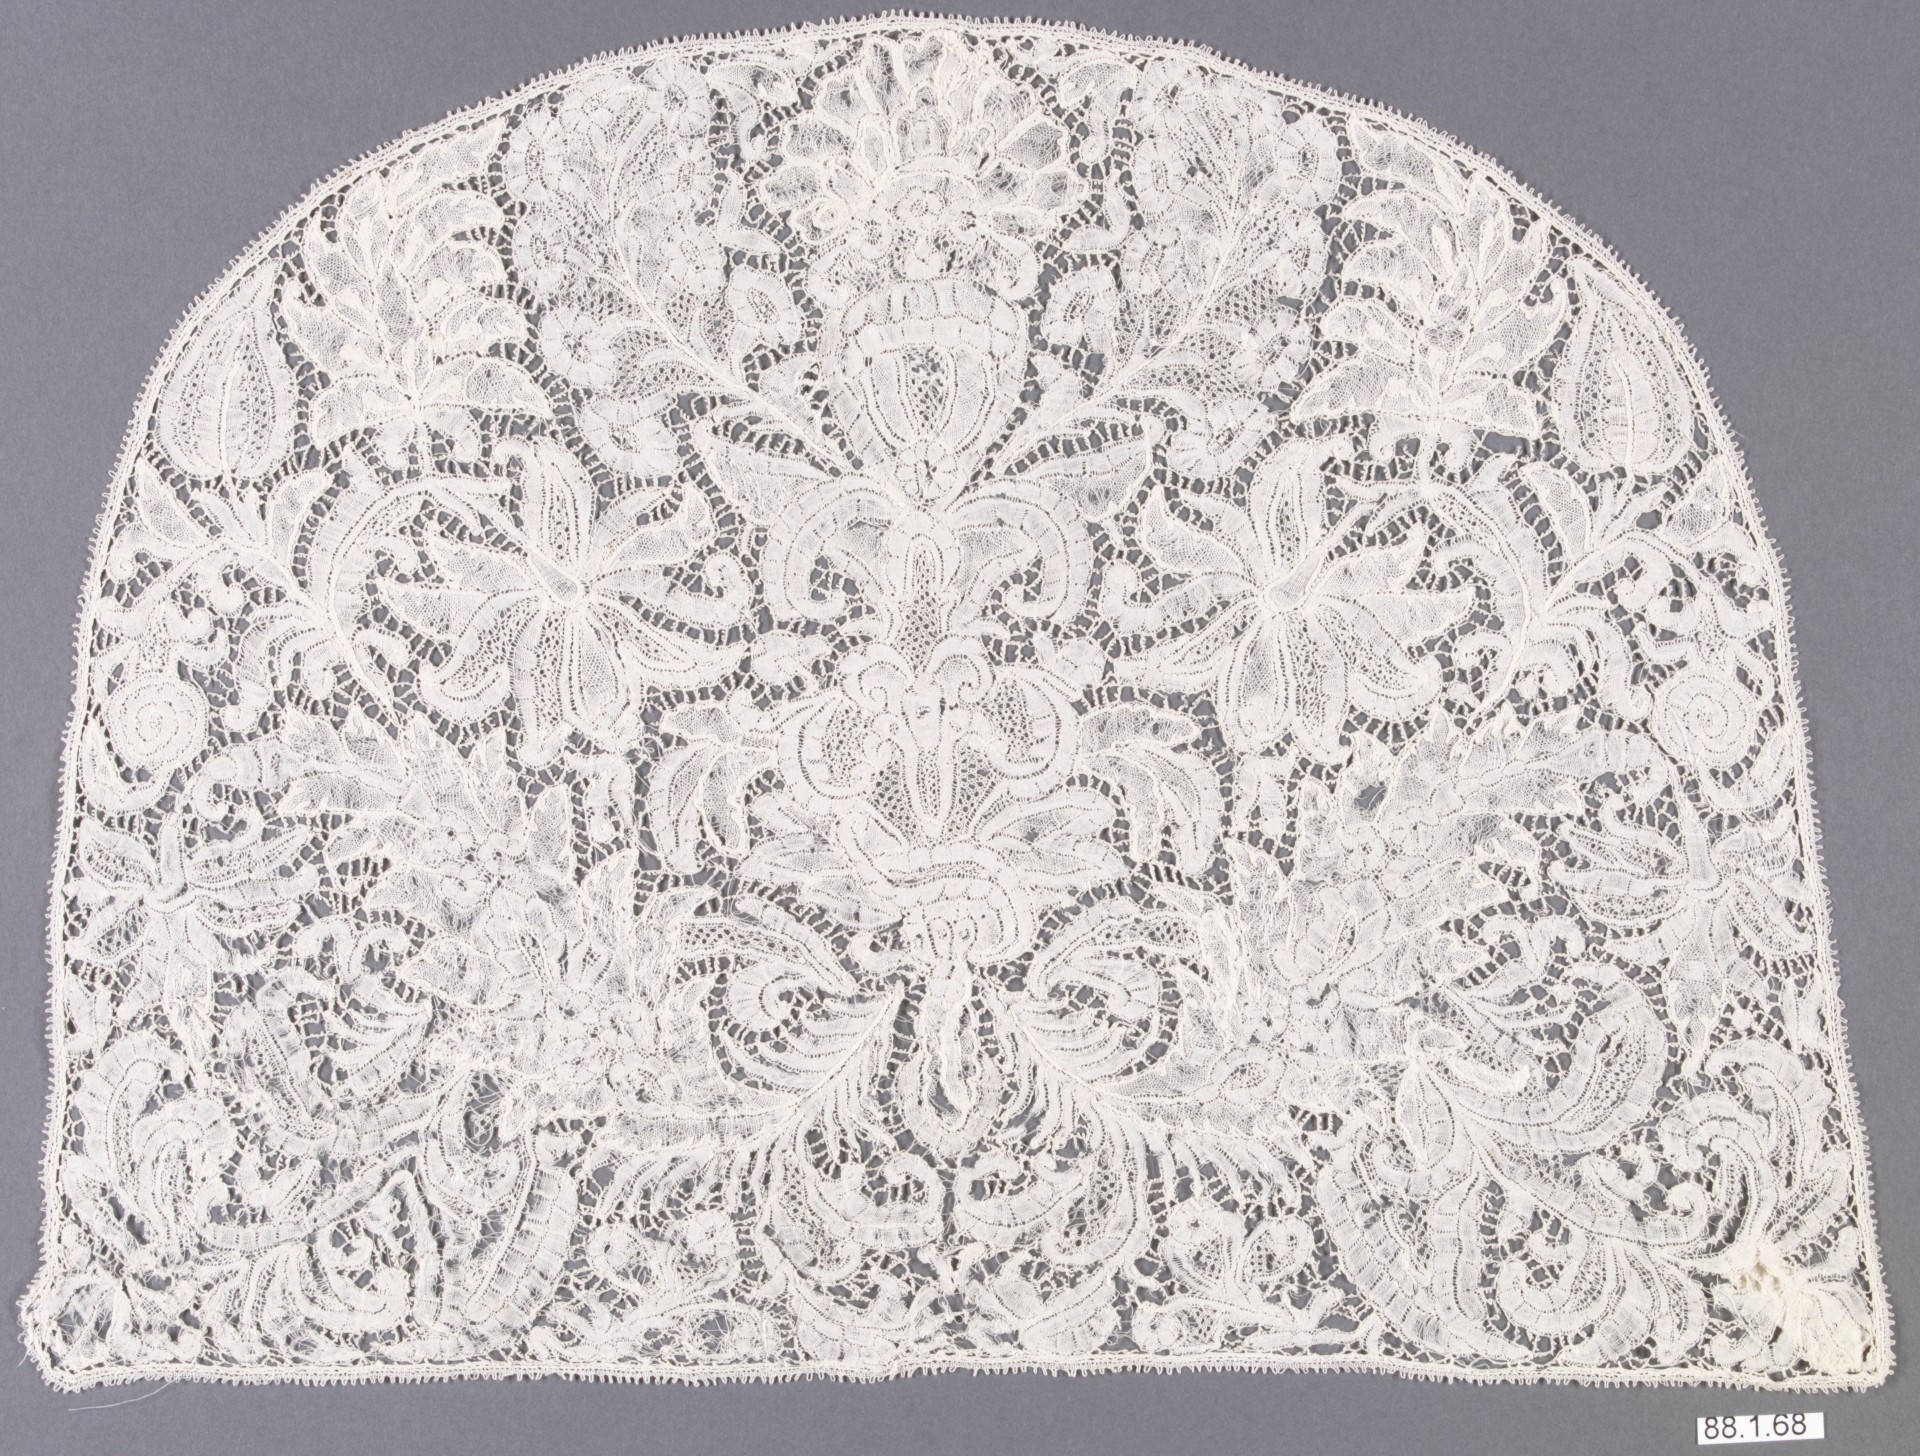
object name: cap crown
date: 1726-1750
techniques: lace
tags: flowers